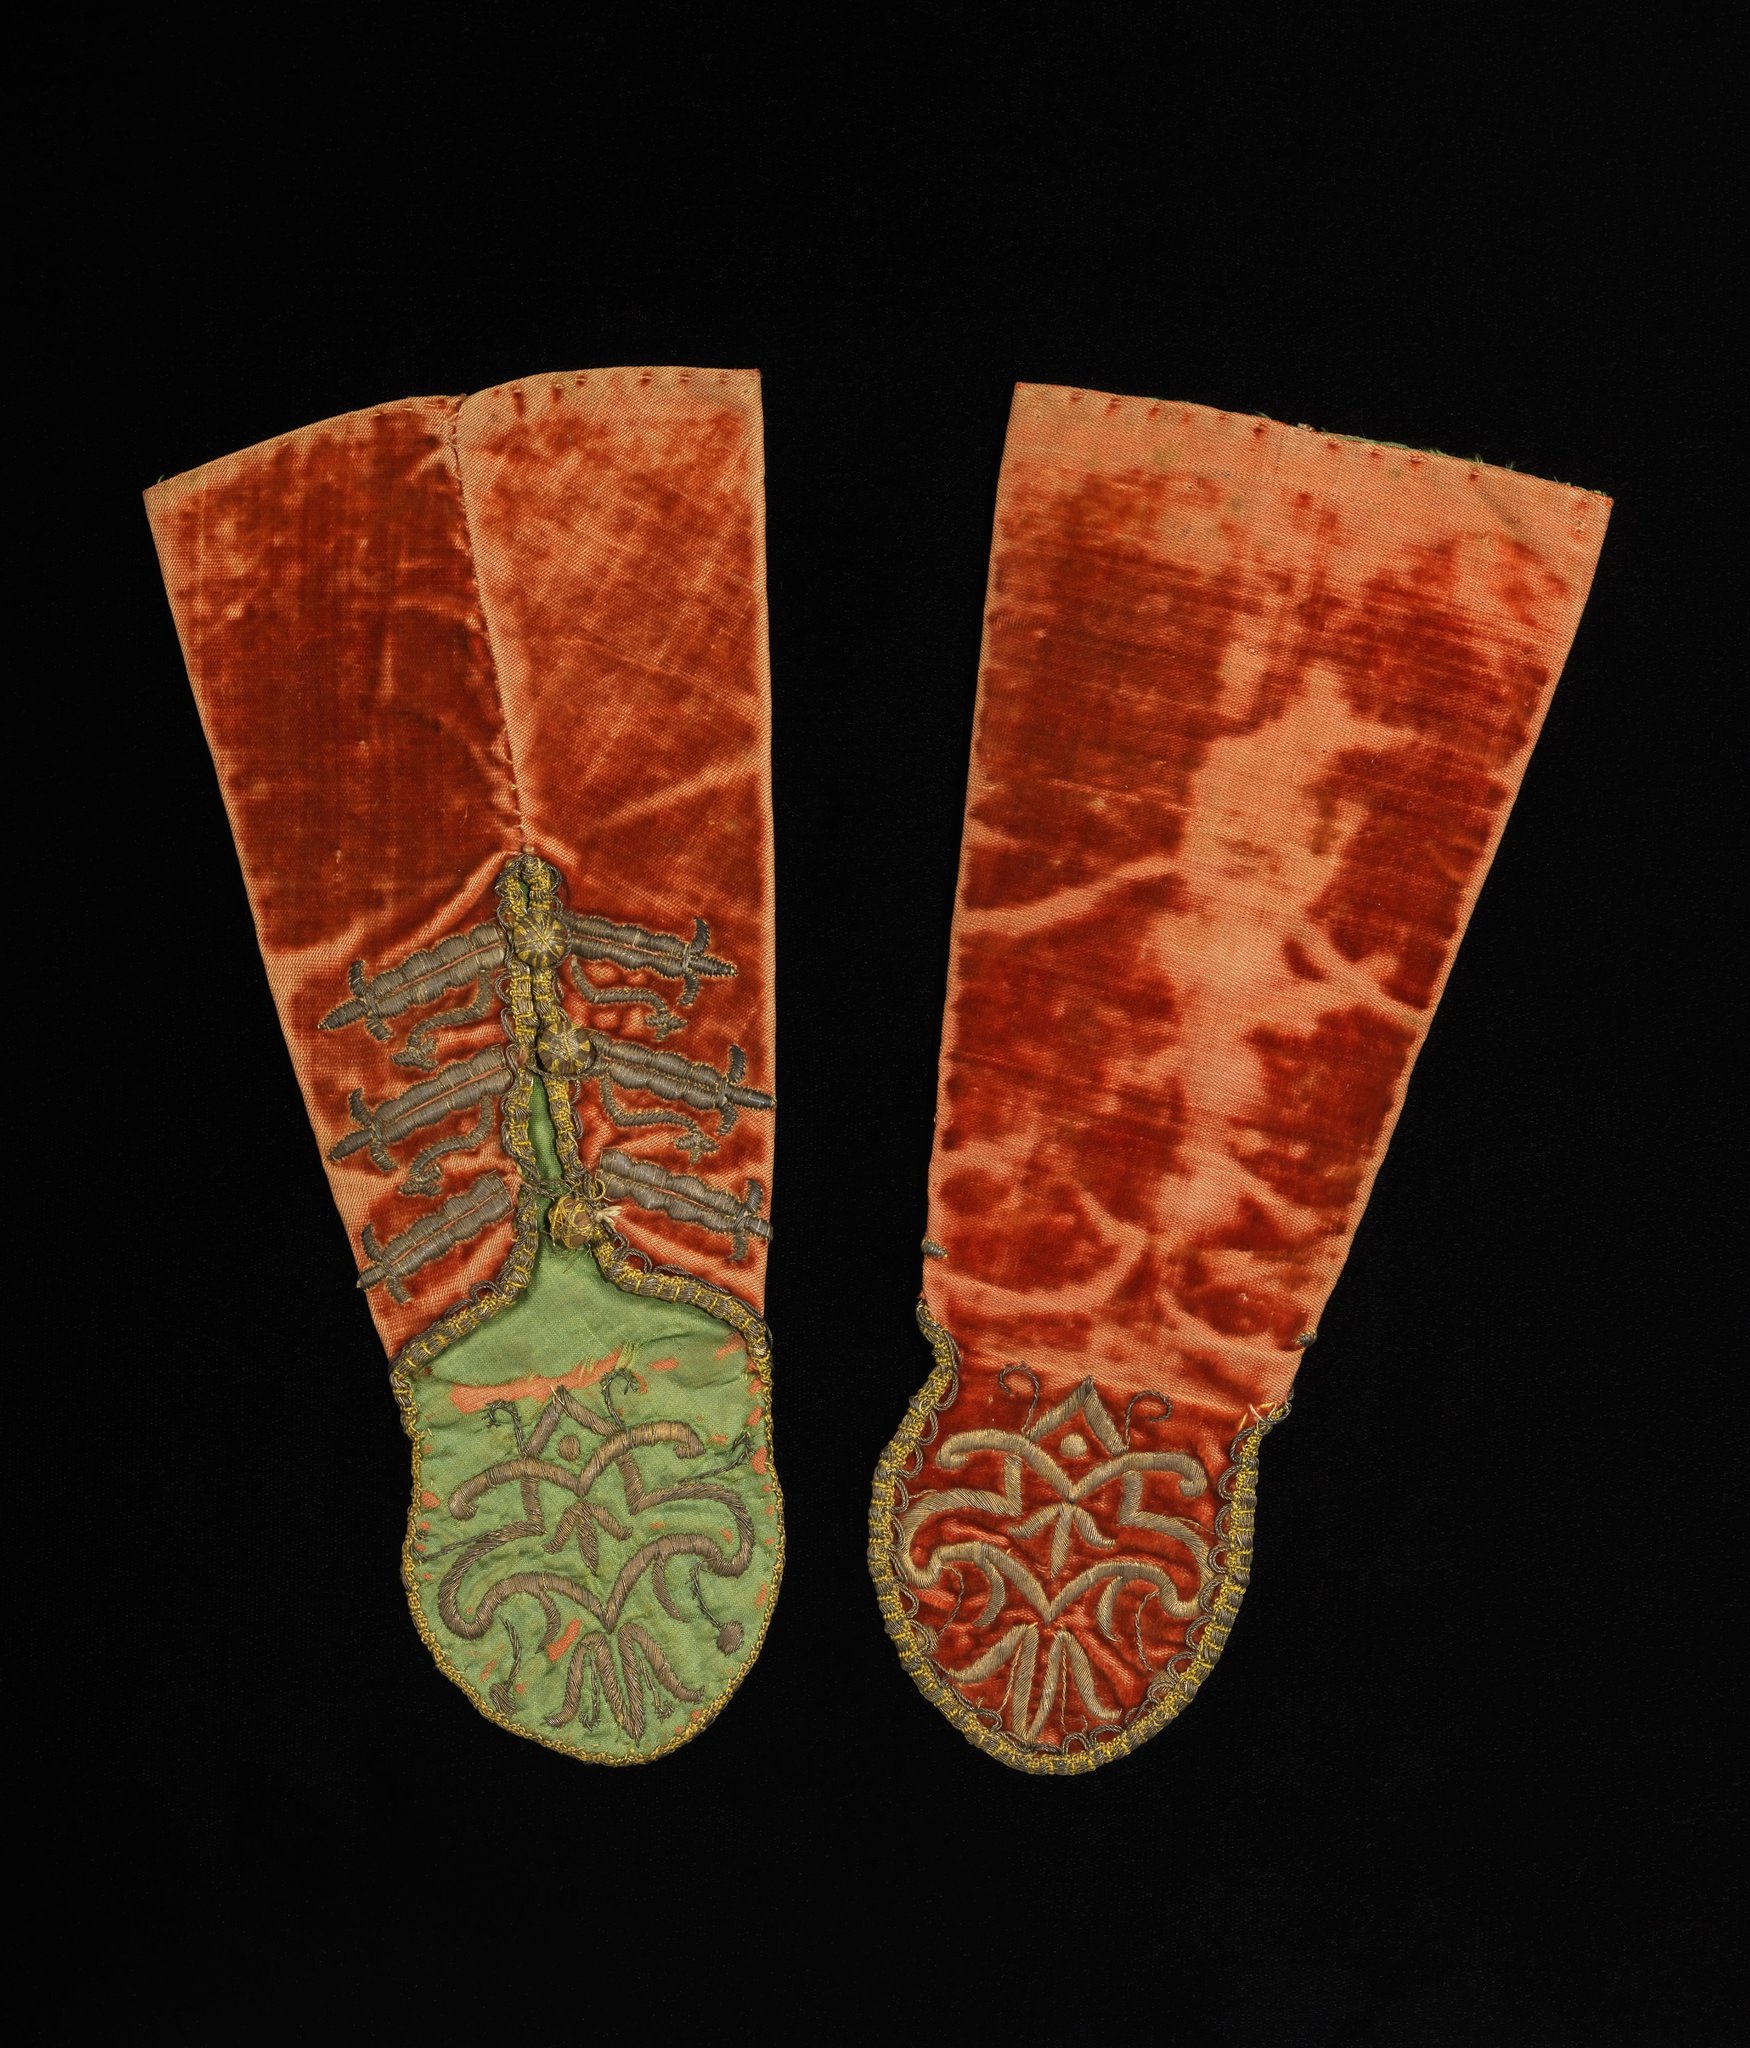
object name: mitt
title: Mitts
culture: italian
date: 1601-1633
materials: metal, silk